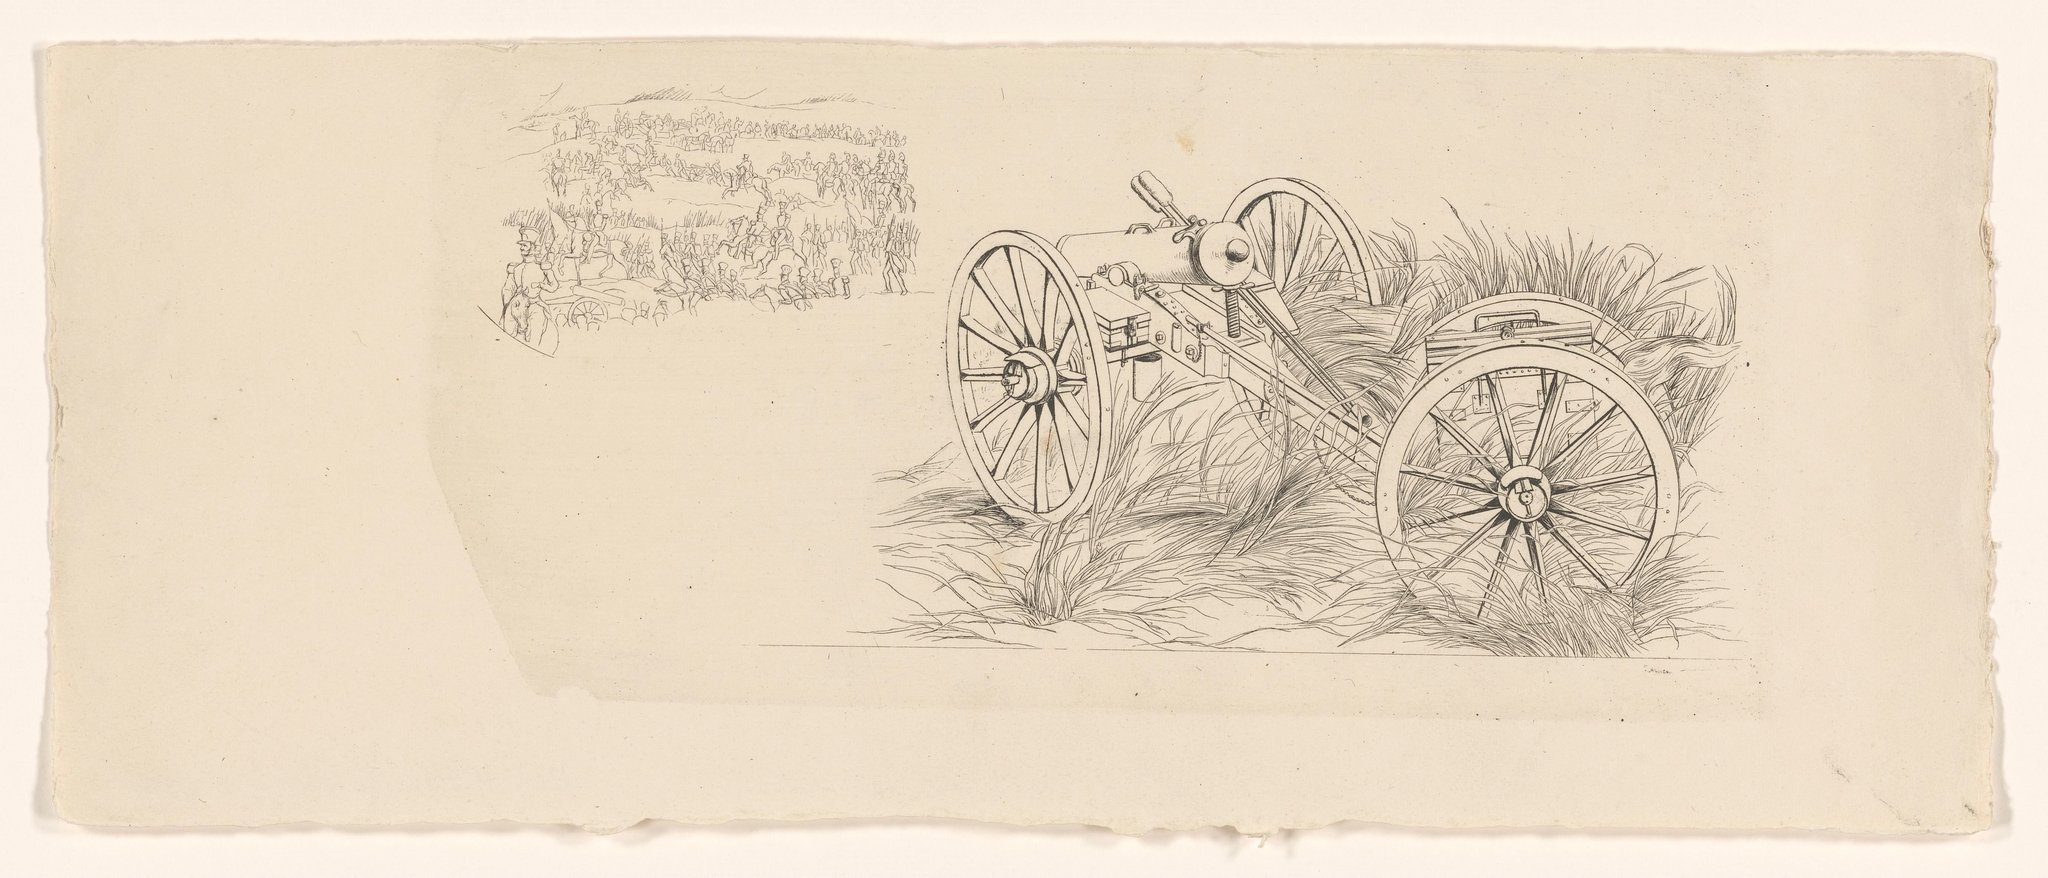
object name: drawing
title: Studie van een veldkanon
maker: jan willem pieneman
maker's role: draughtsman, painter, print maker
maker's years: 1779-1853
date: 1789-1853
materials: ink, paper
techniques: brush, pen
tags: firearms: cannon